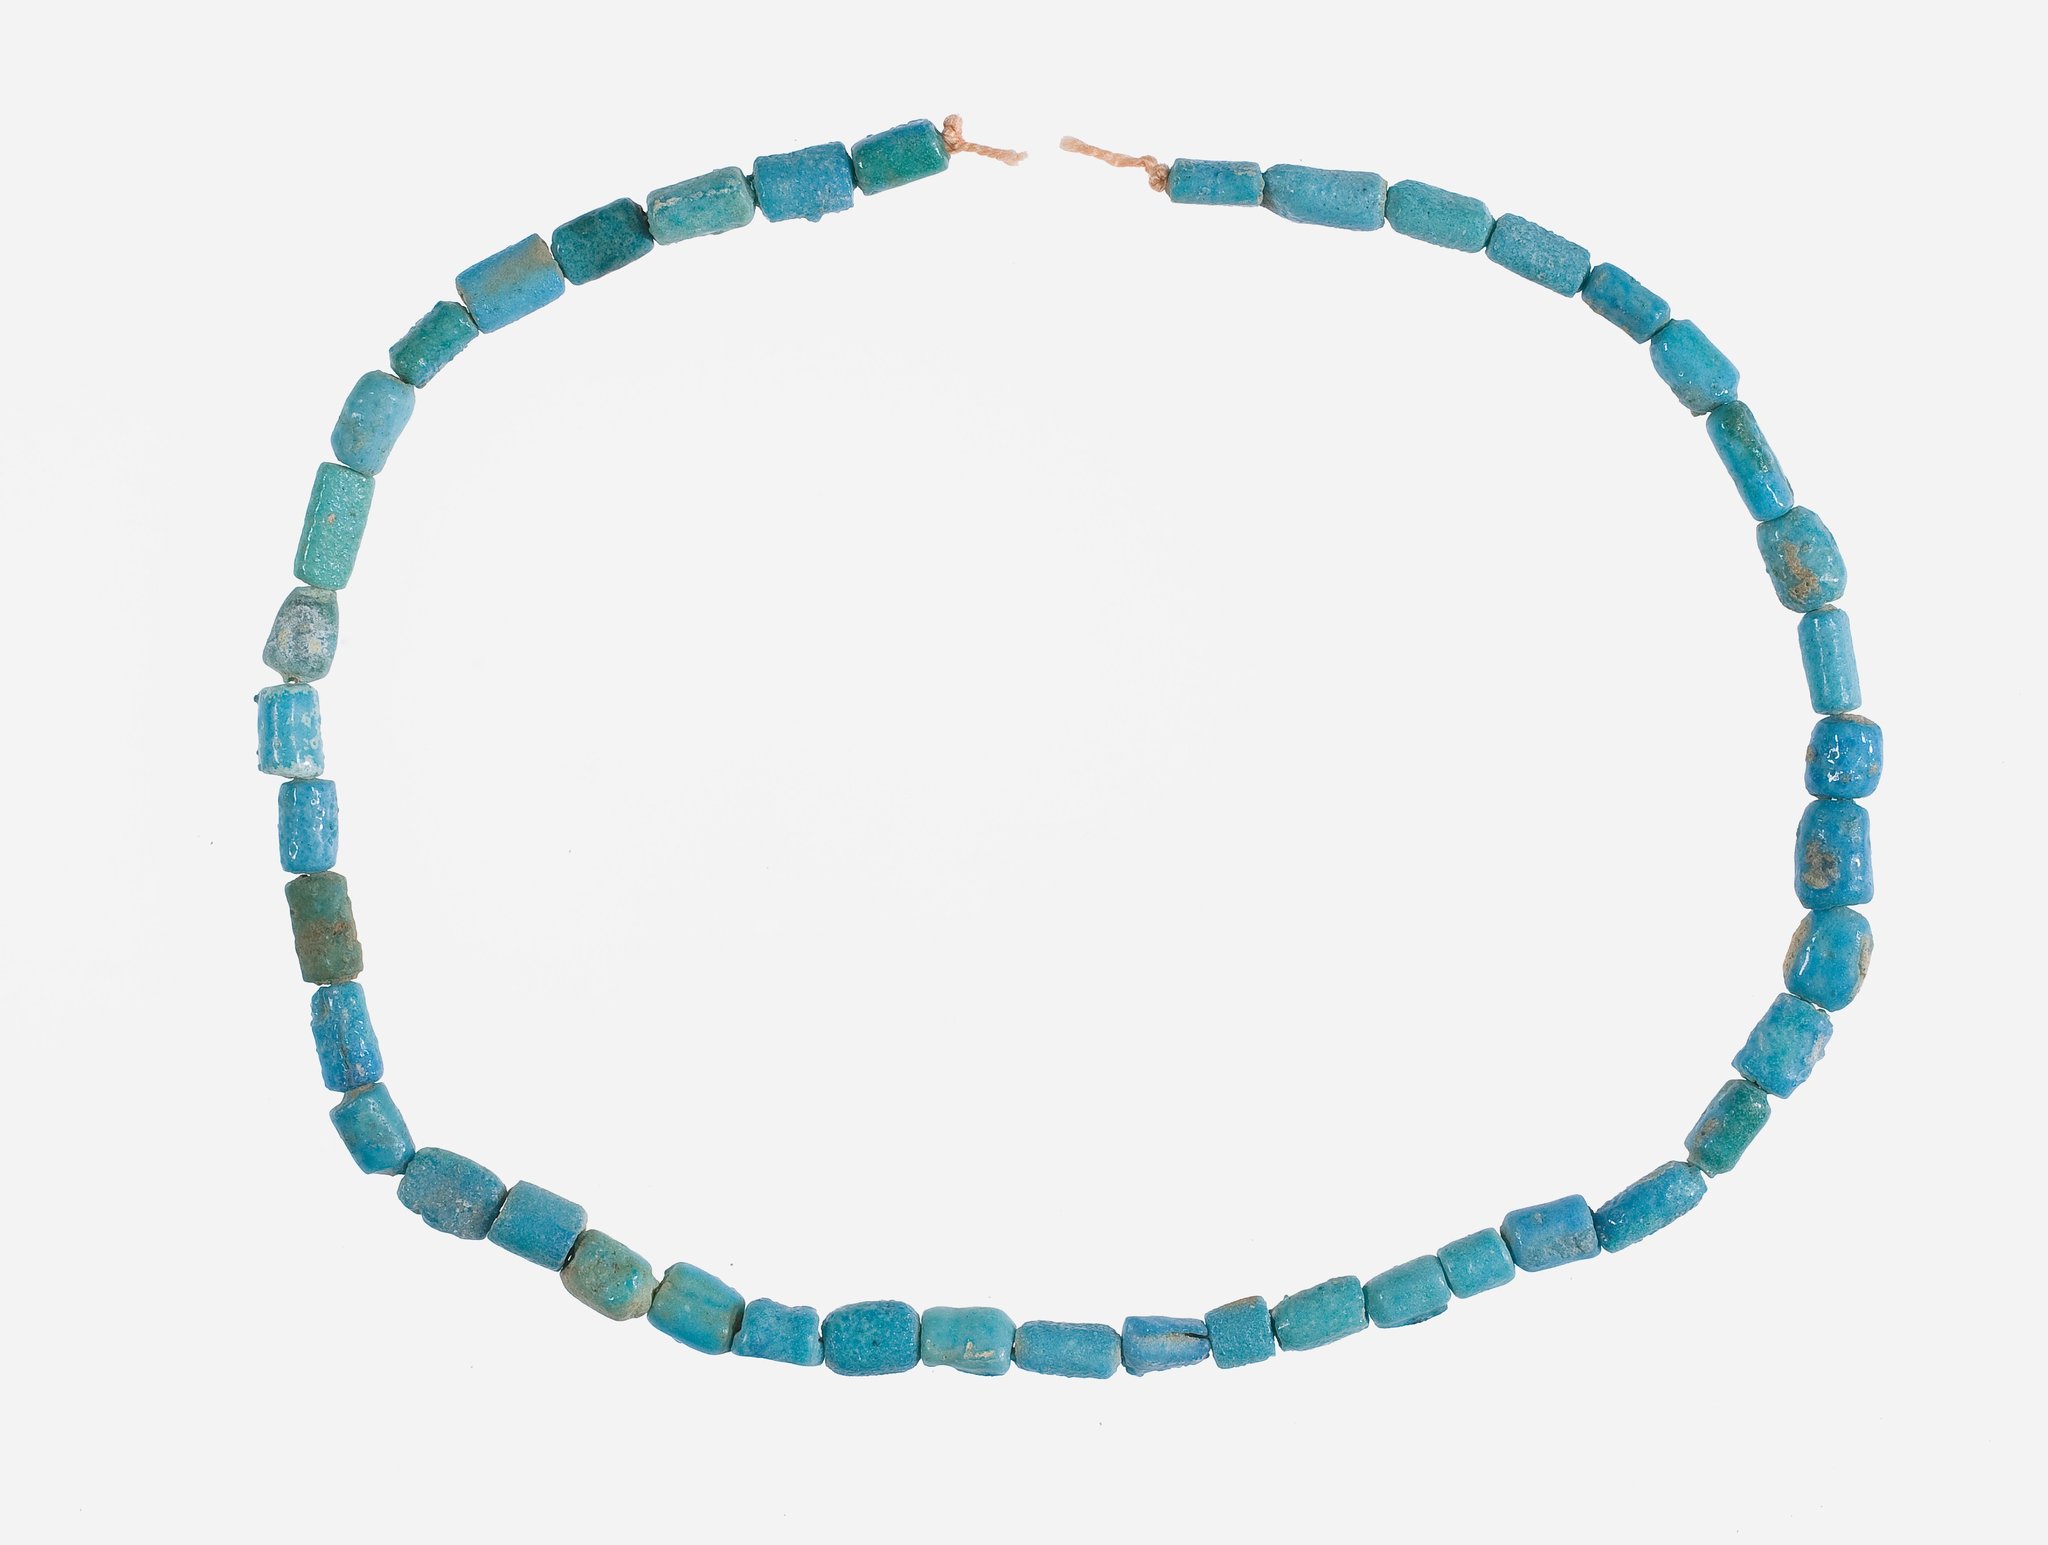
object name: bead, cylinder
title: String of Short Cylindrical Beads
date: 1390-1352 BCE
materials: faience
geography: egypt